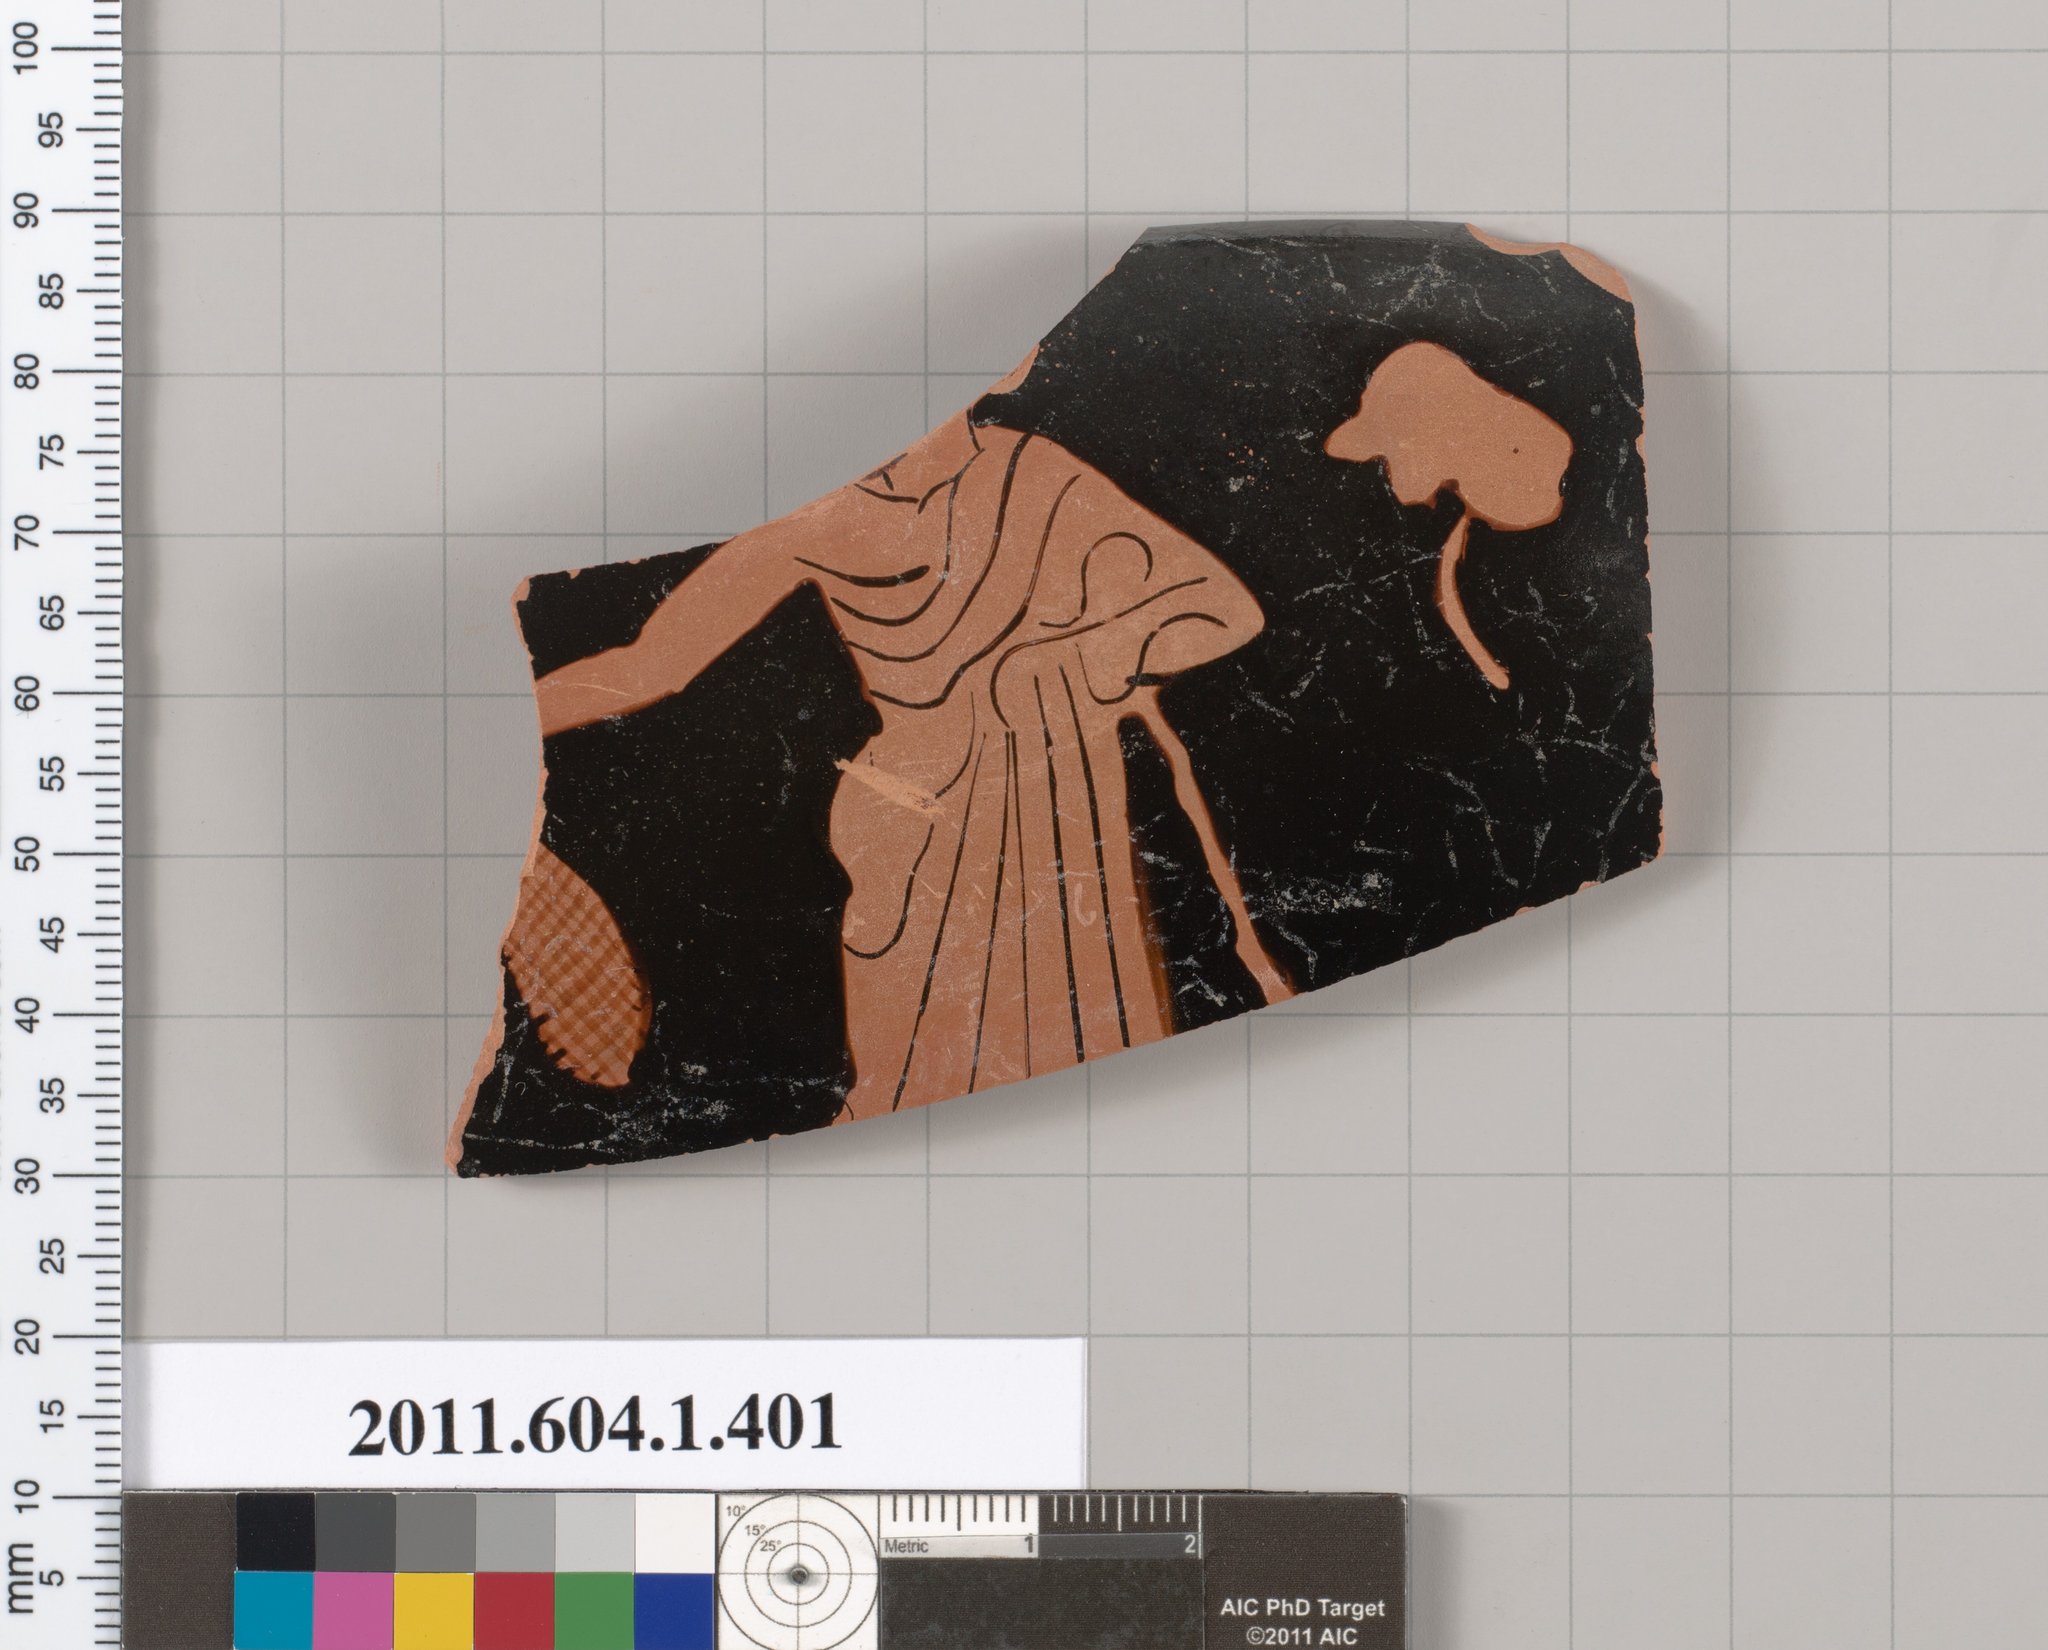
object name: kylix fragment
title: Terracotta fragment of a kylix (drinking cup)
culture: greek, attic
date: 475-451 BCE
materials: terracotta